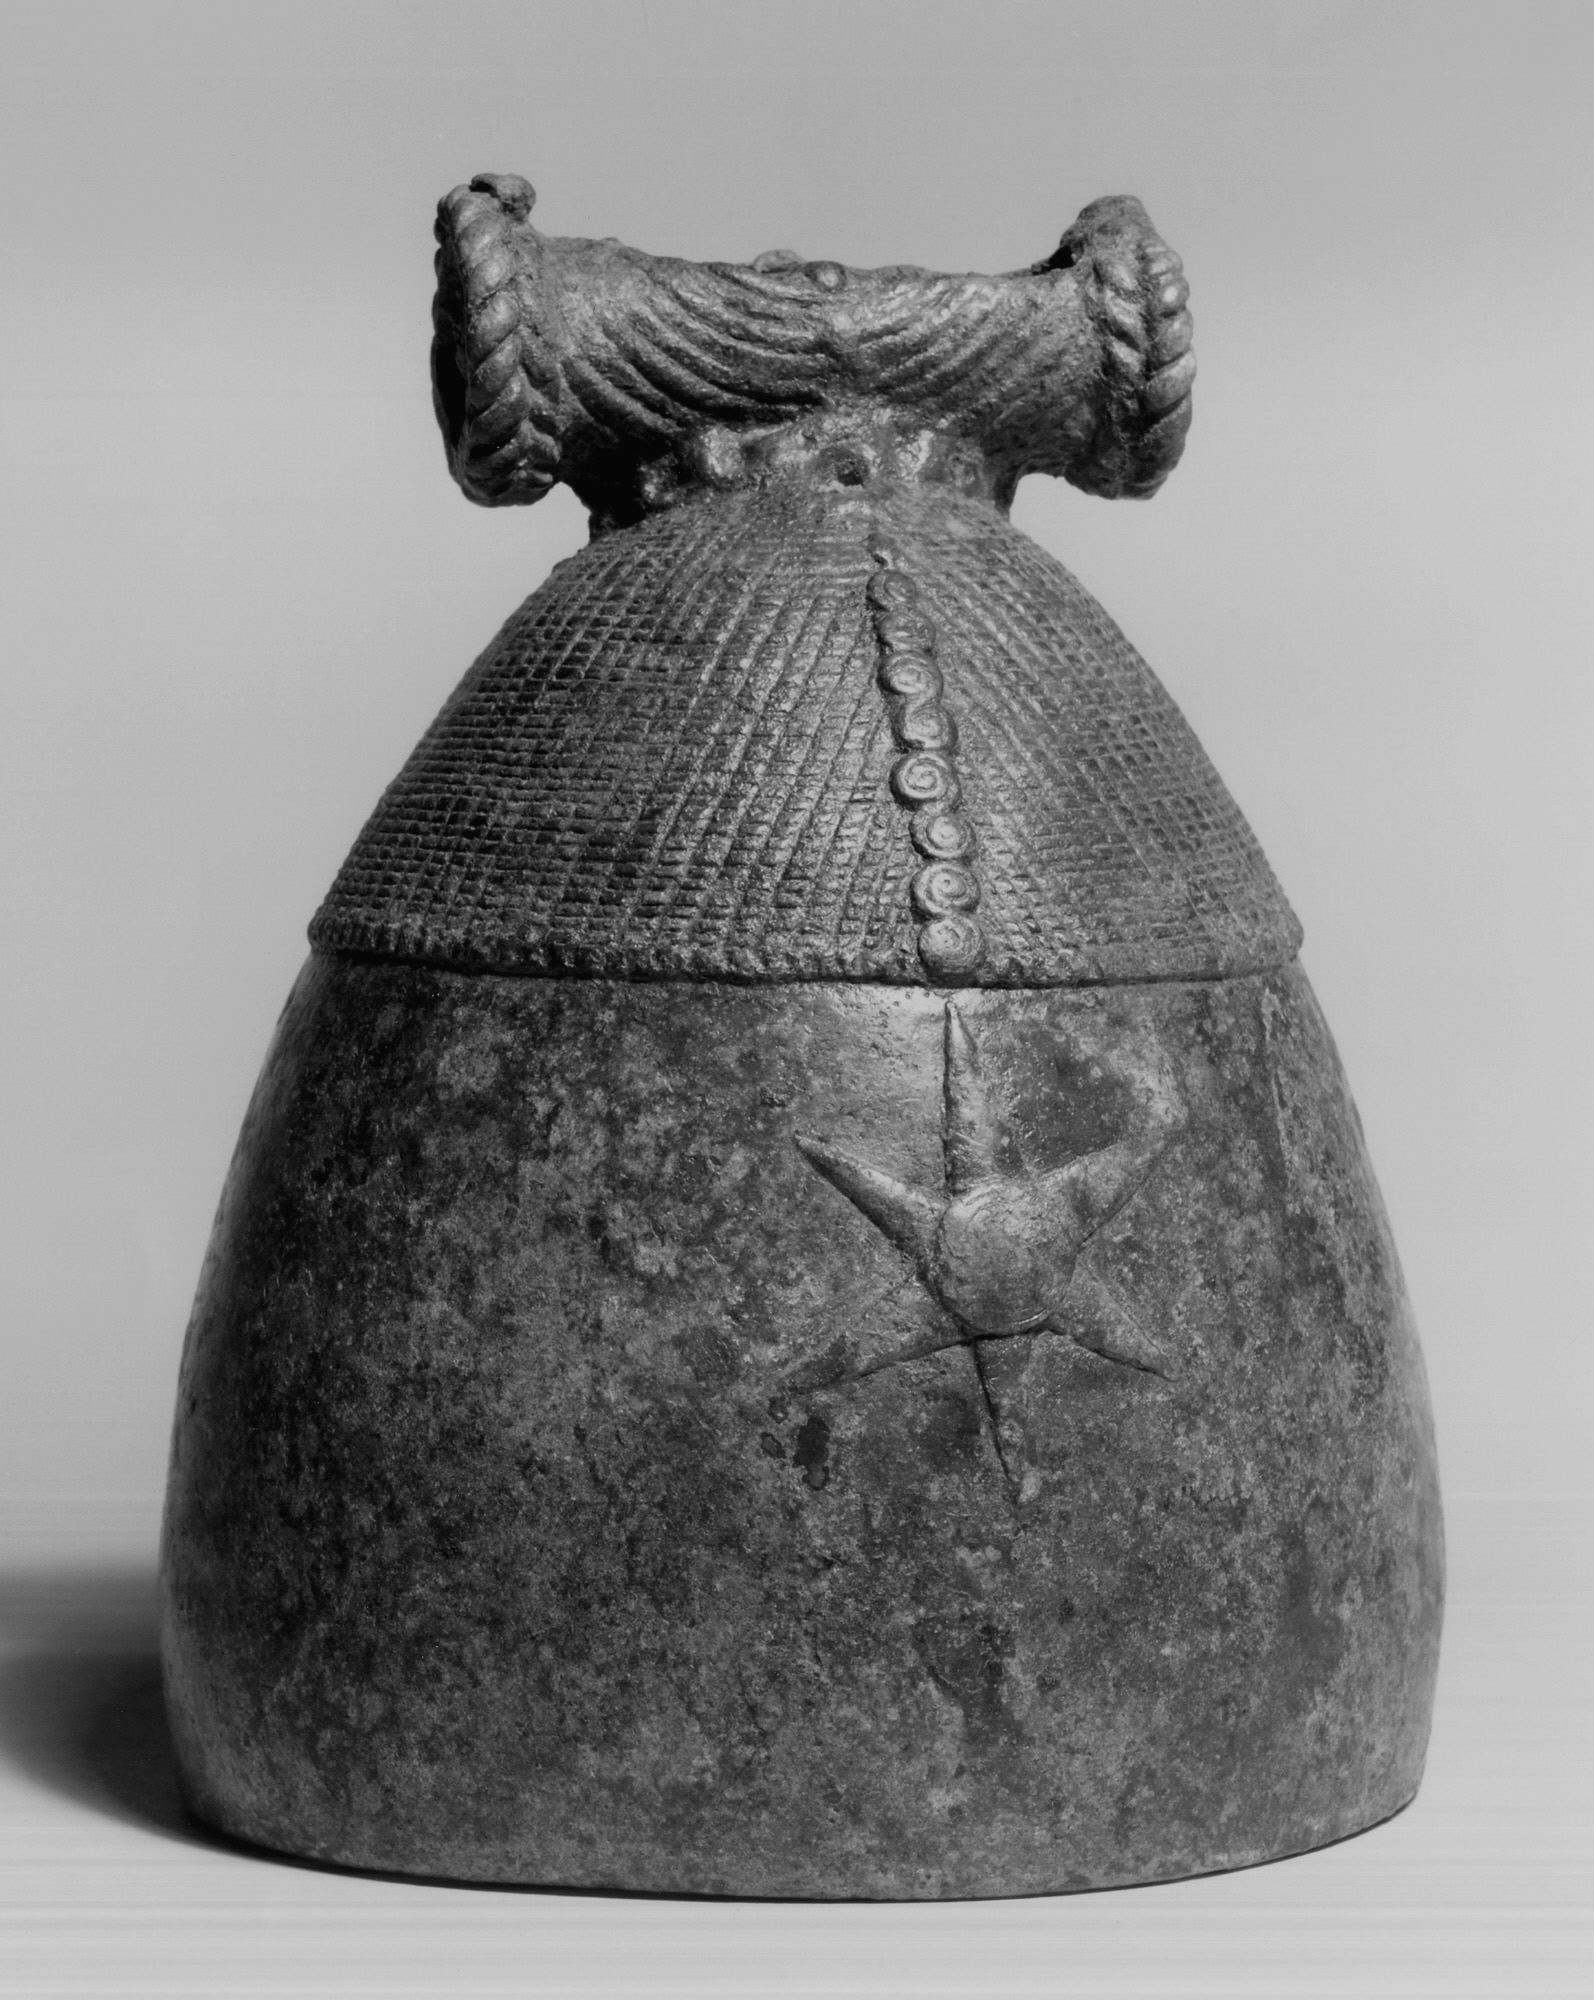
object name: bell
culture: thai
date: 300 BCE-200 CE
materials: bronze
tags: musical instruments,stars